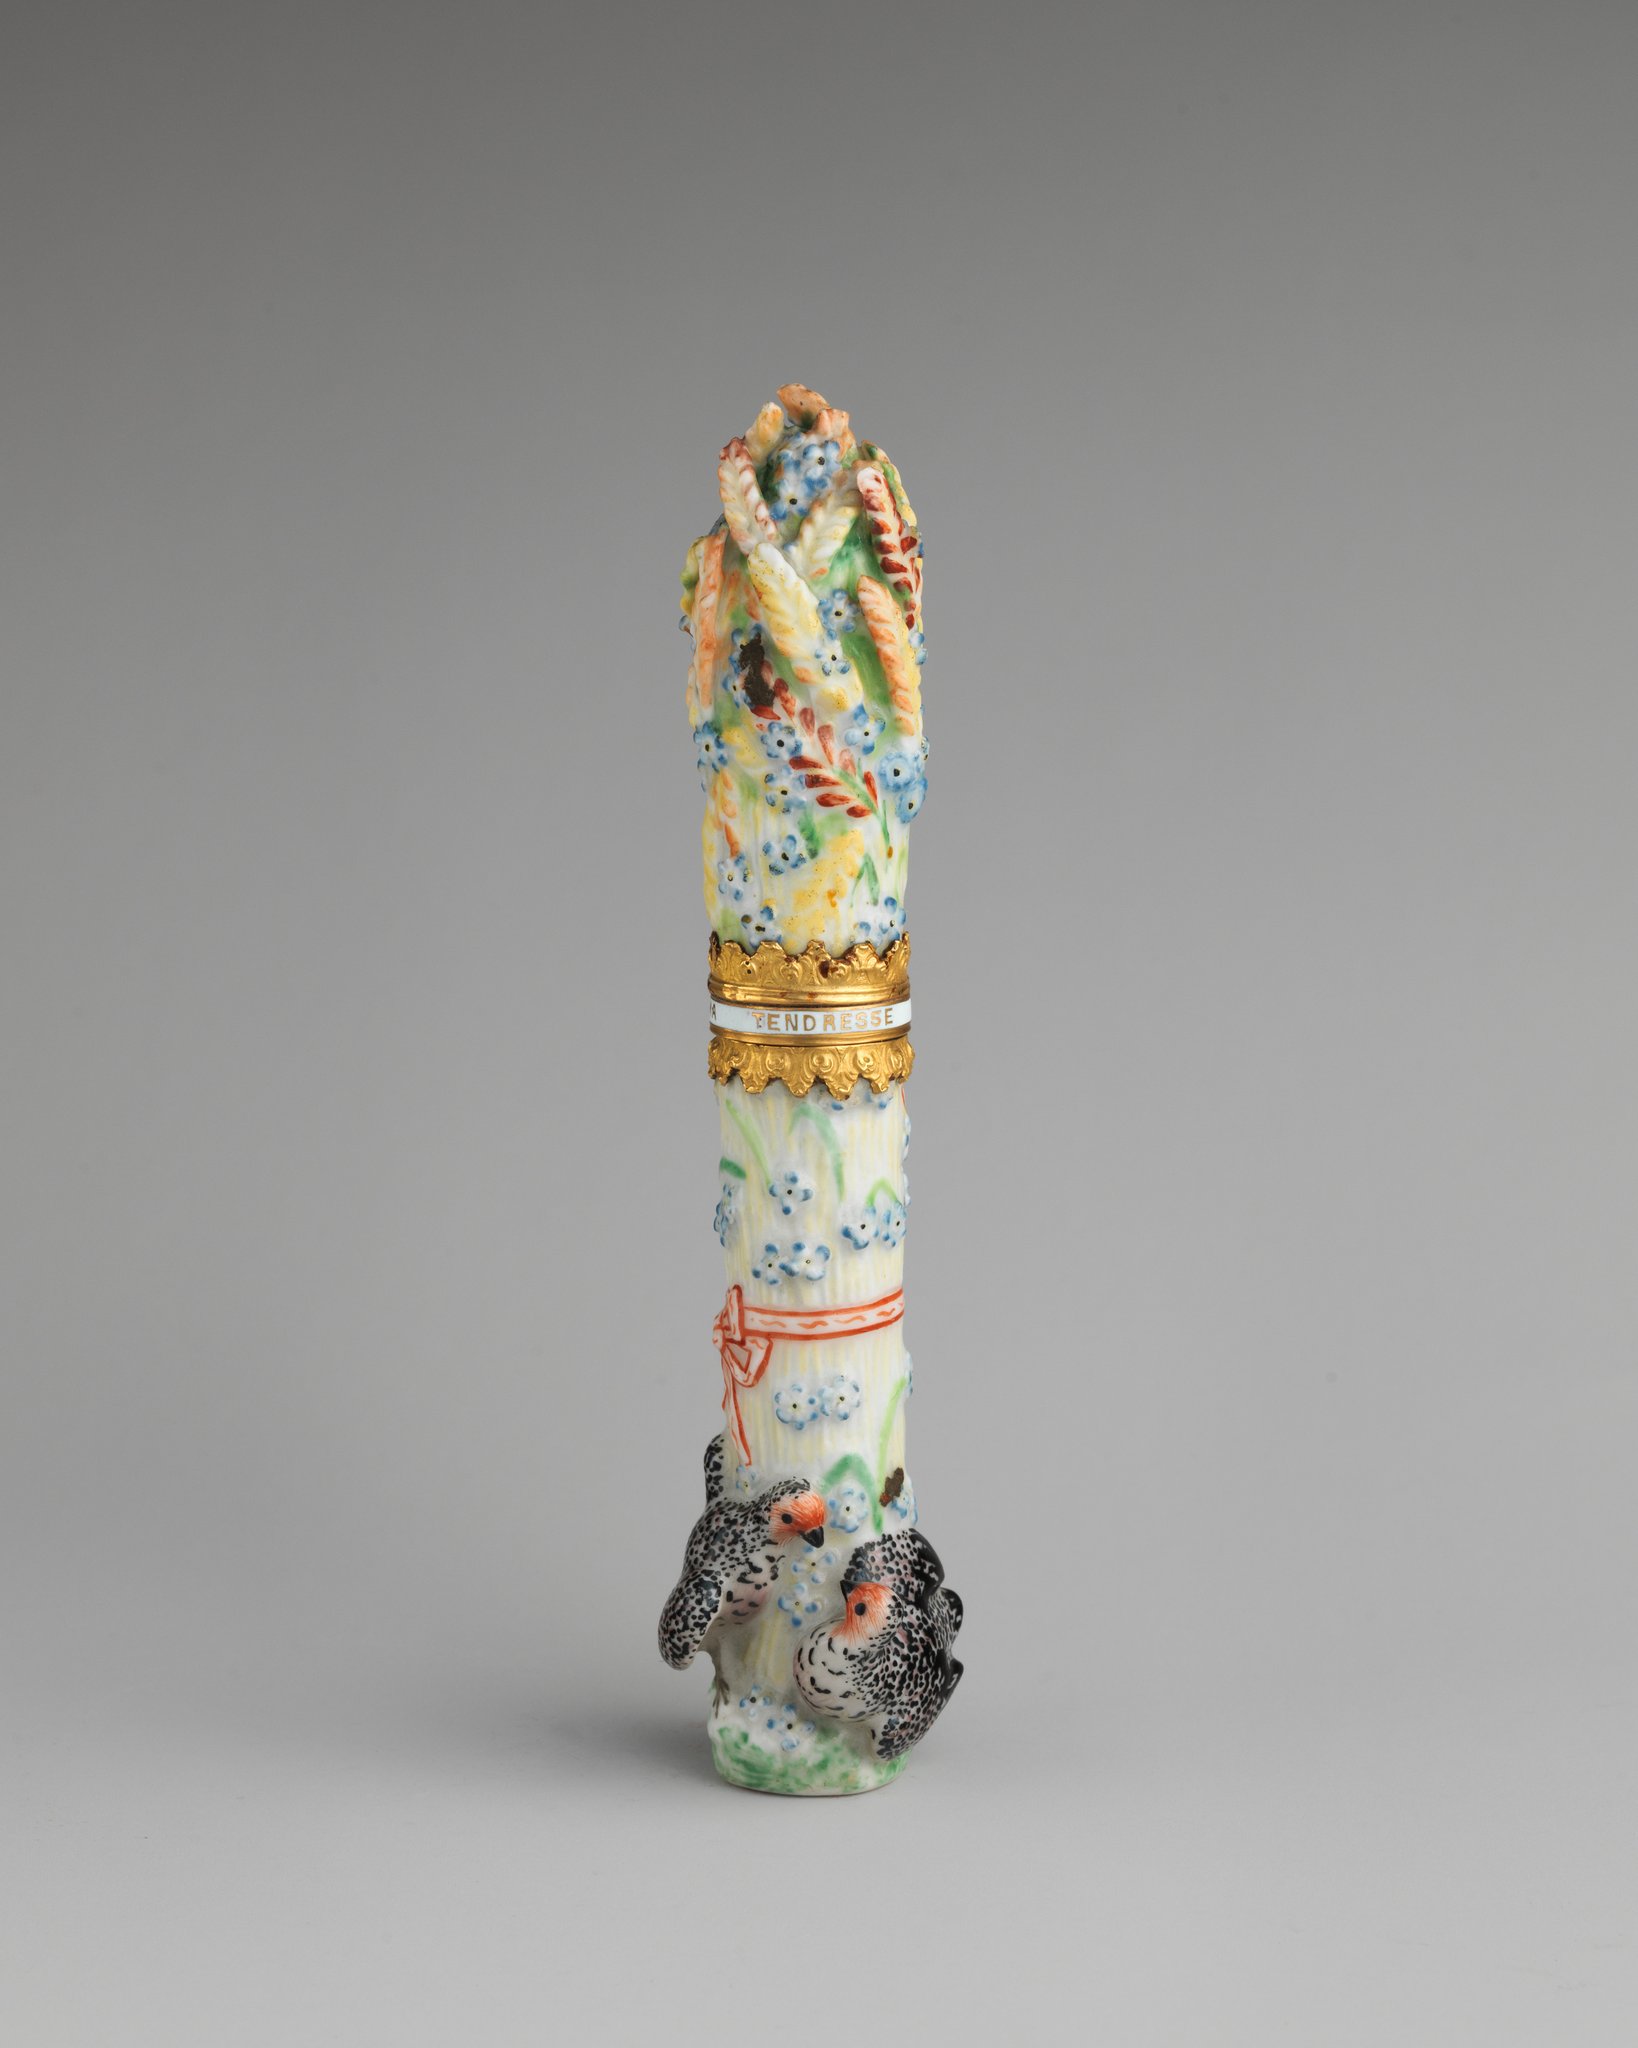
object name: toy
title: Partridges in wheatsheaf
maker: chelsea porcelain manufactory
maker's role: factory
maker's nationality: british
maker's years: 1744-1784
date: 1755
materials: soft paste porcelain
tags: birds,flowers,leaves